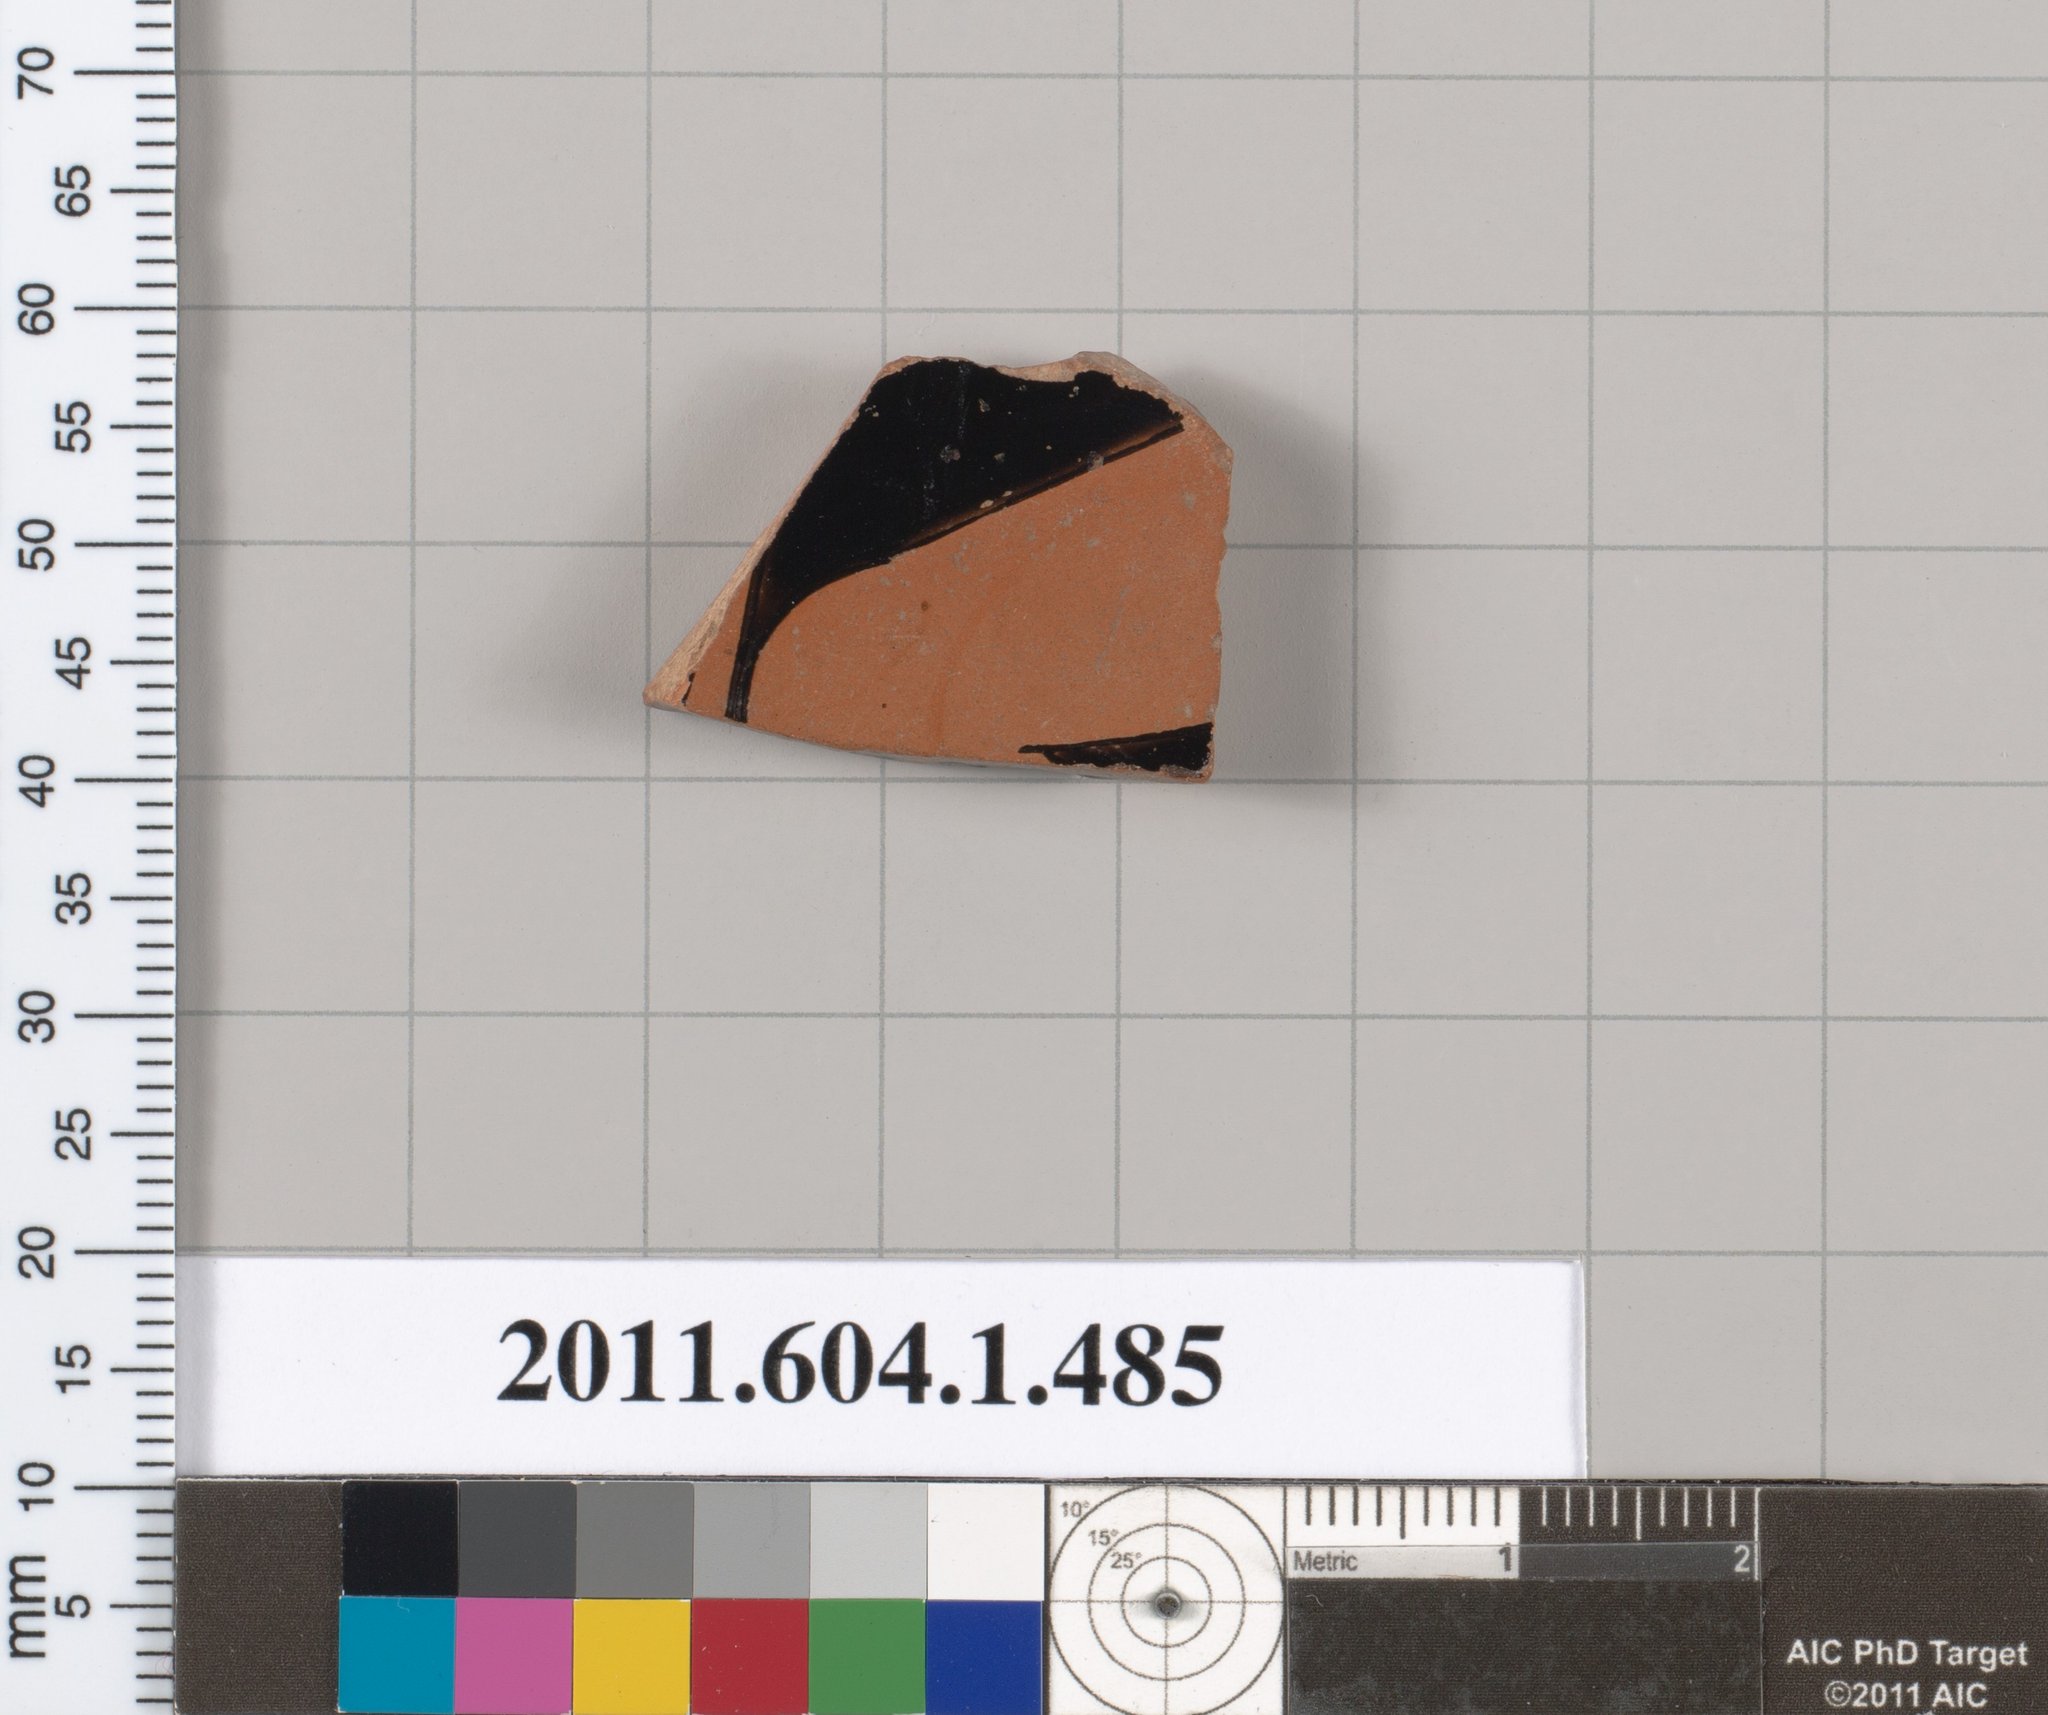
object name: kylix fragment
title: Terracotta fragment of a kylix (drinking cup)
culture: greek, attic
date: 490-480 BCE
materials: terracotta